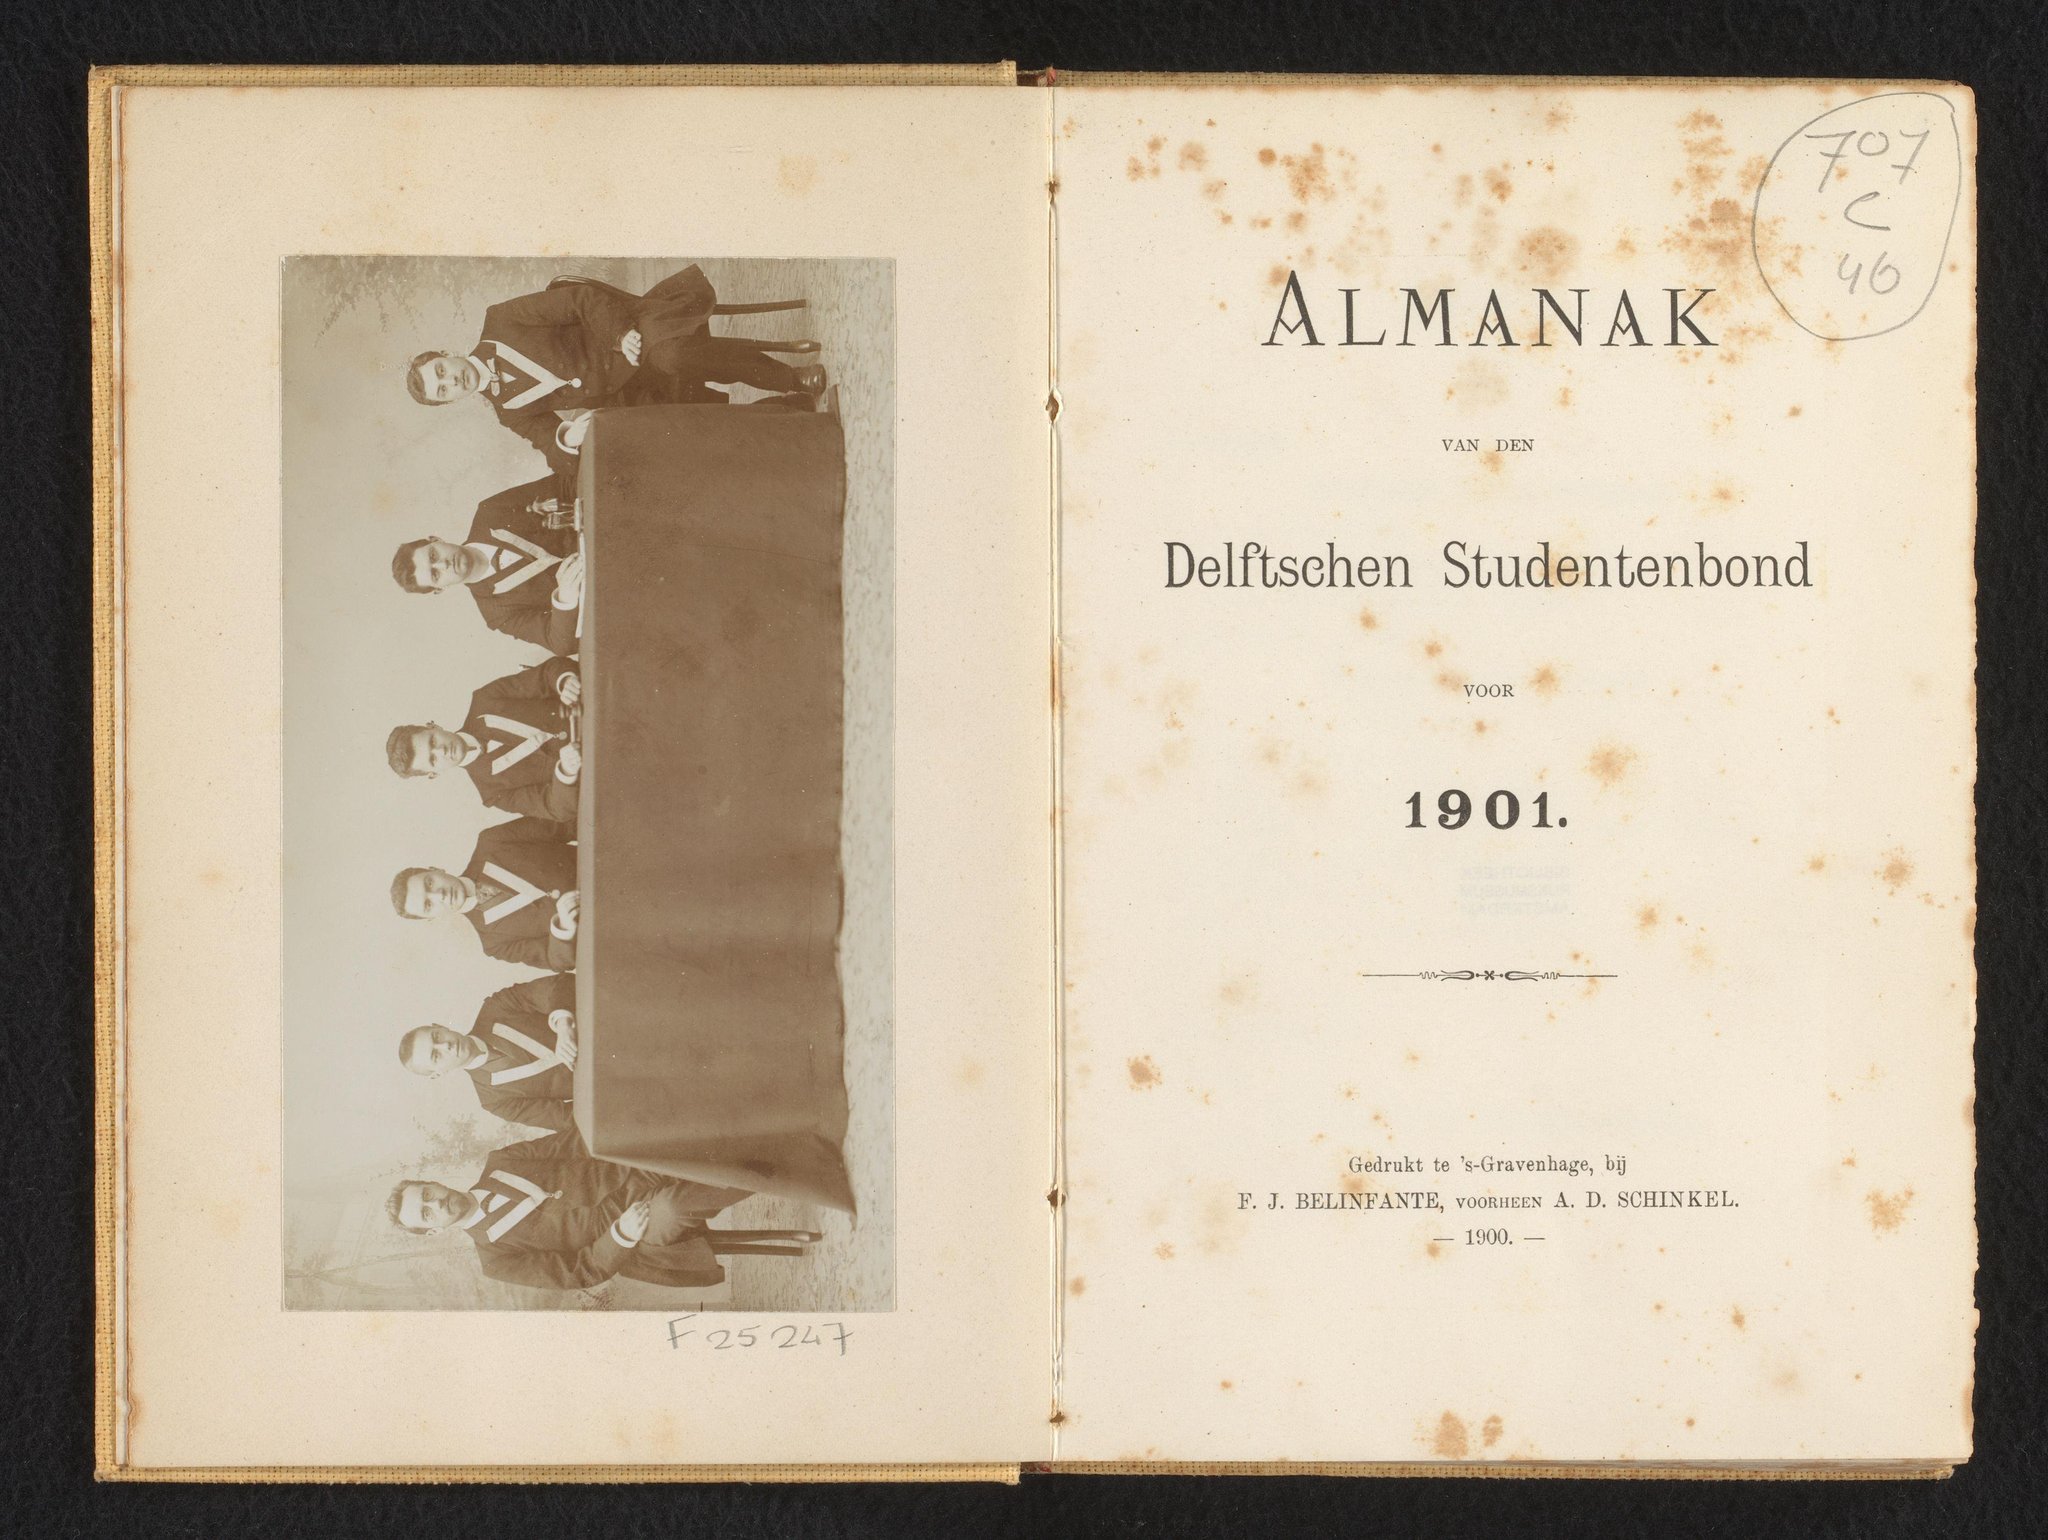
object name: book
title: Almanak van den Delftschen Studentenbond voor 1901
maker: frederik joseph cohen belinfante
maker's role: boekdrukker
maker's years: 1843-1910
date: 1900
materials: paper, cardboard, linen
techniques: letterpress printing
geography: the hague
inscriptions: inscription: ‘Spoorwegen 25,-/ opl. ± 100/ stuks’